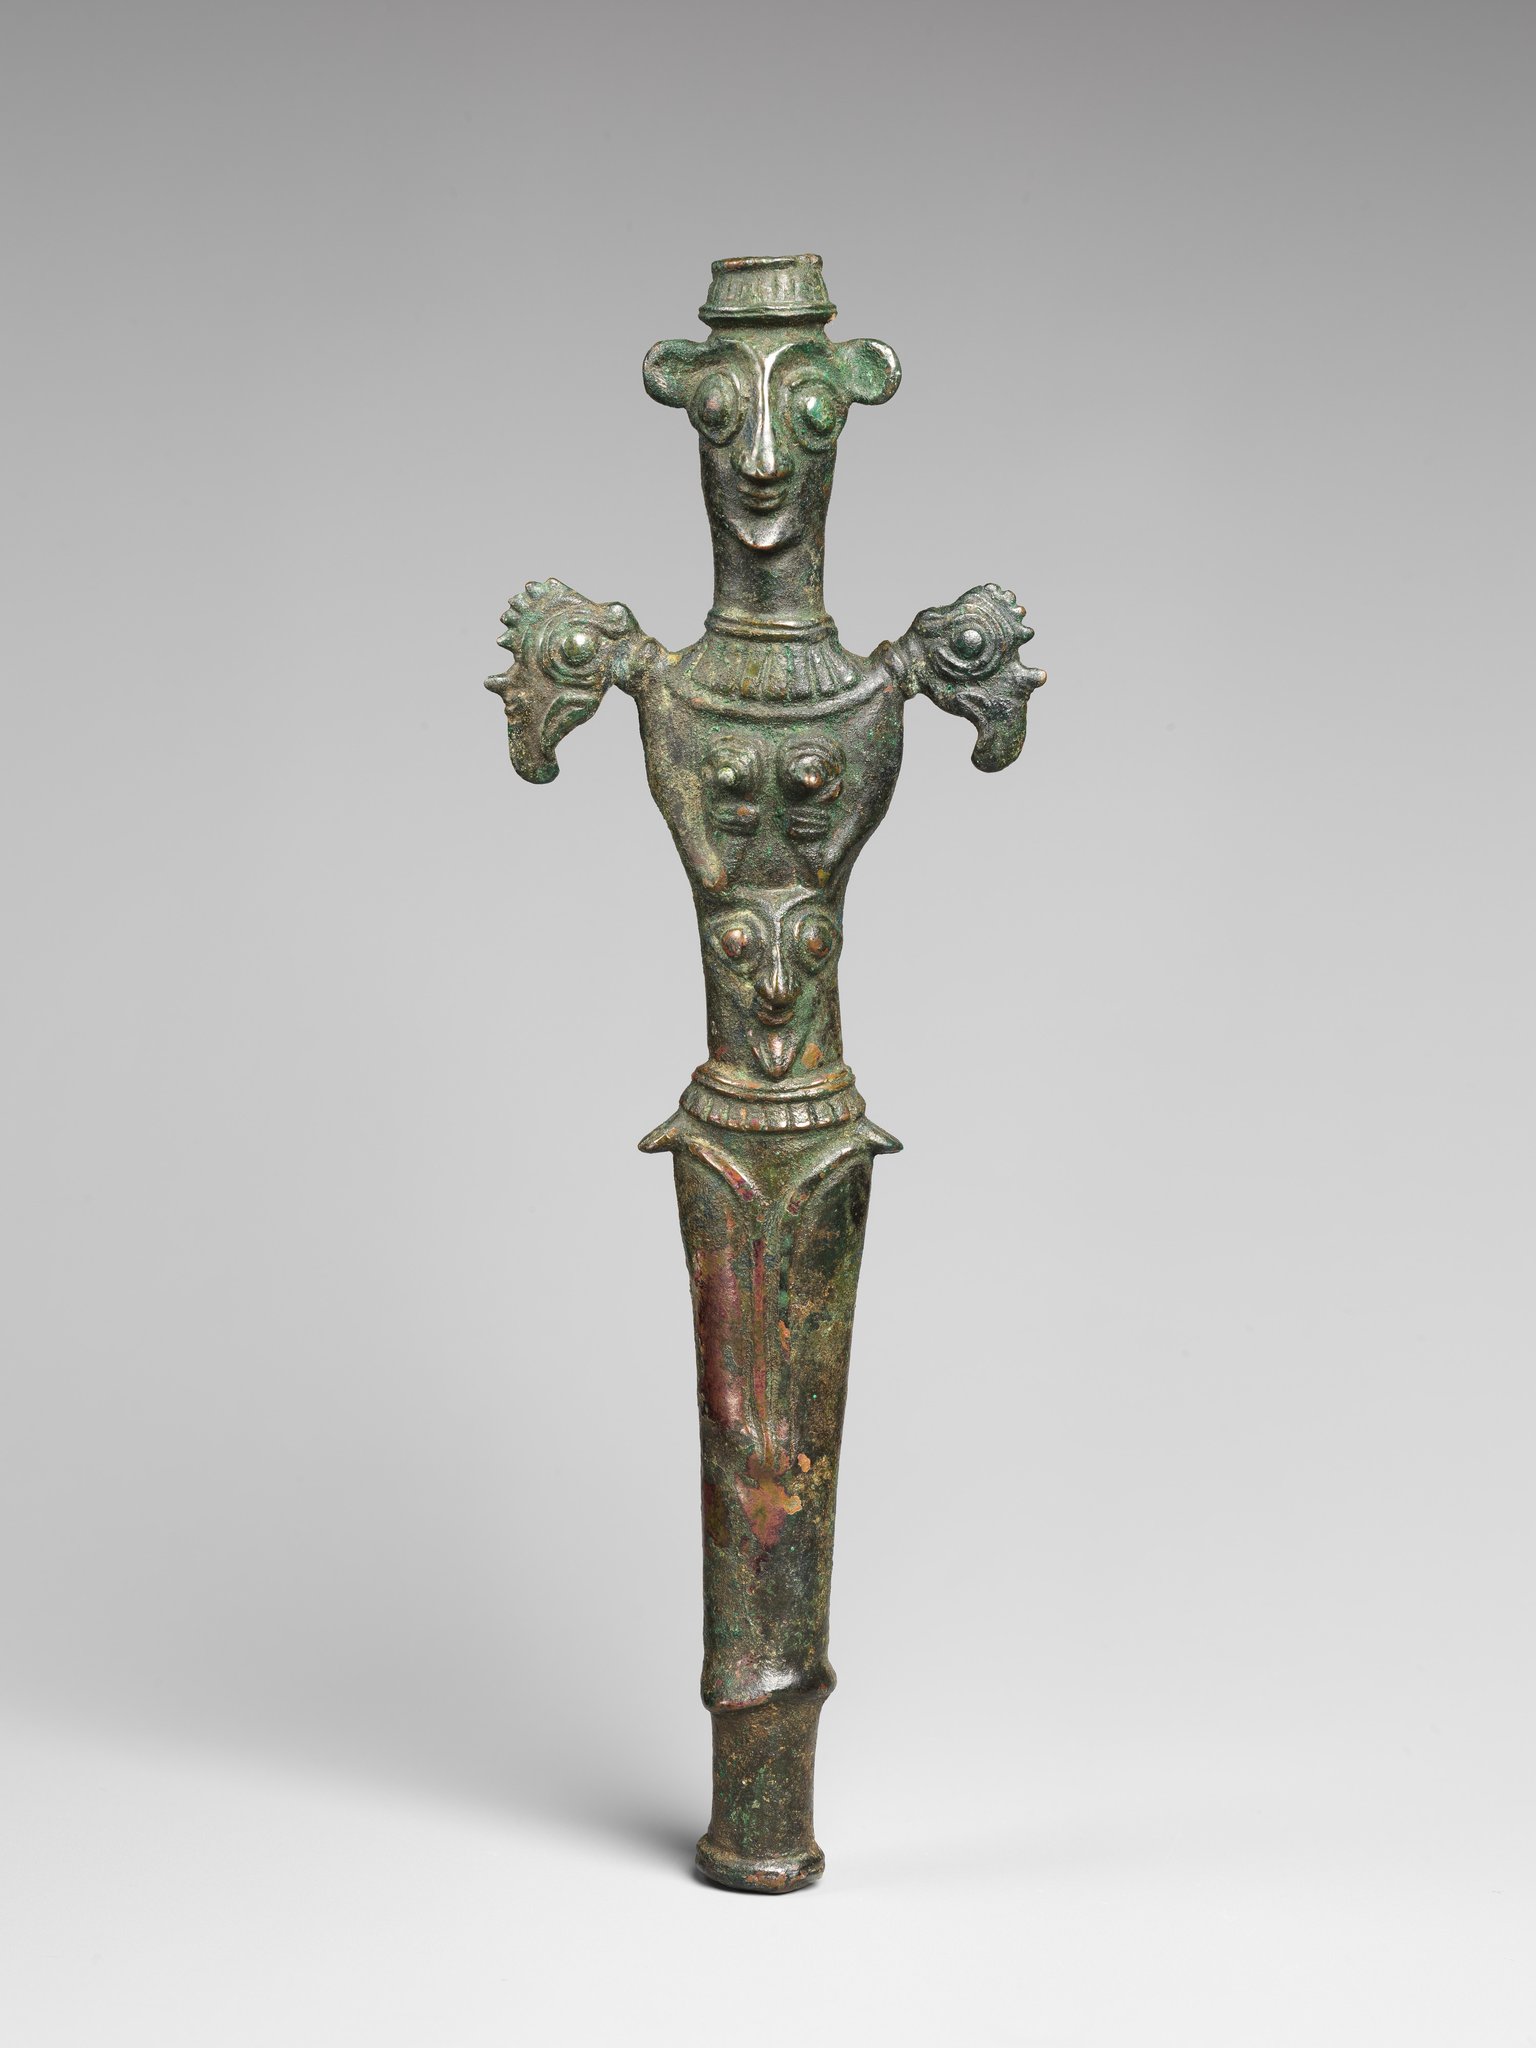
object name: standard top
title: Top for standard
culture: iranian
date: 800-601 BCE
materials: bronze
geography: iran, probably from luristan